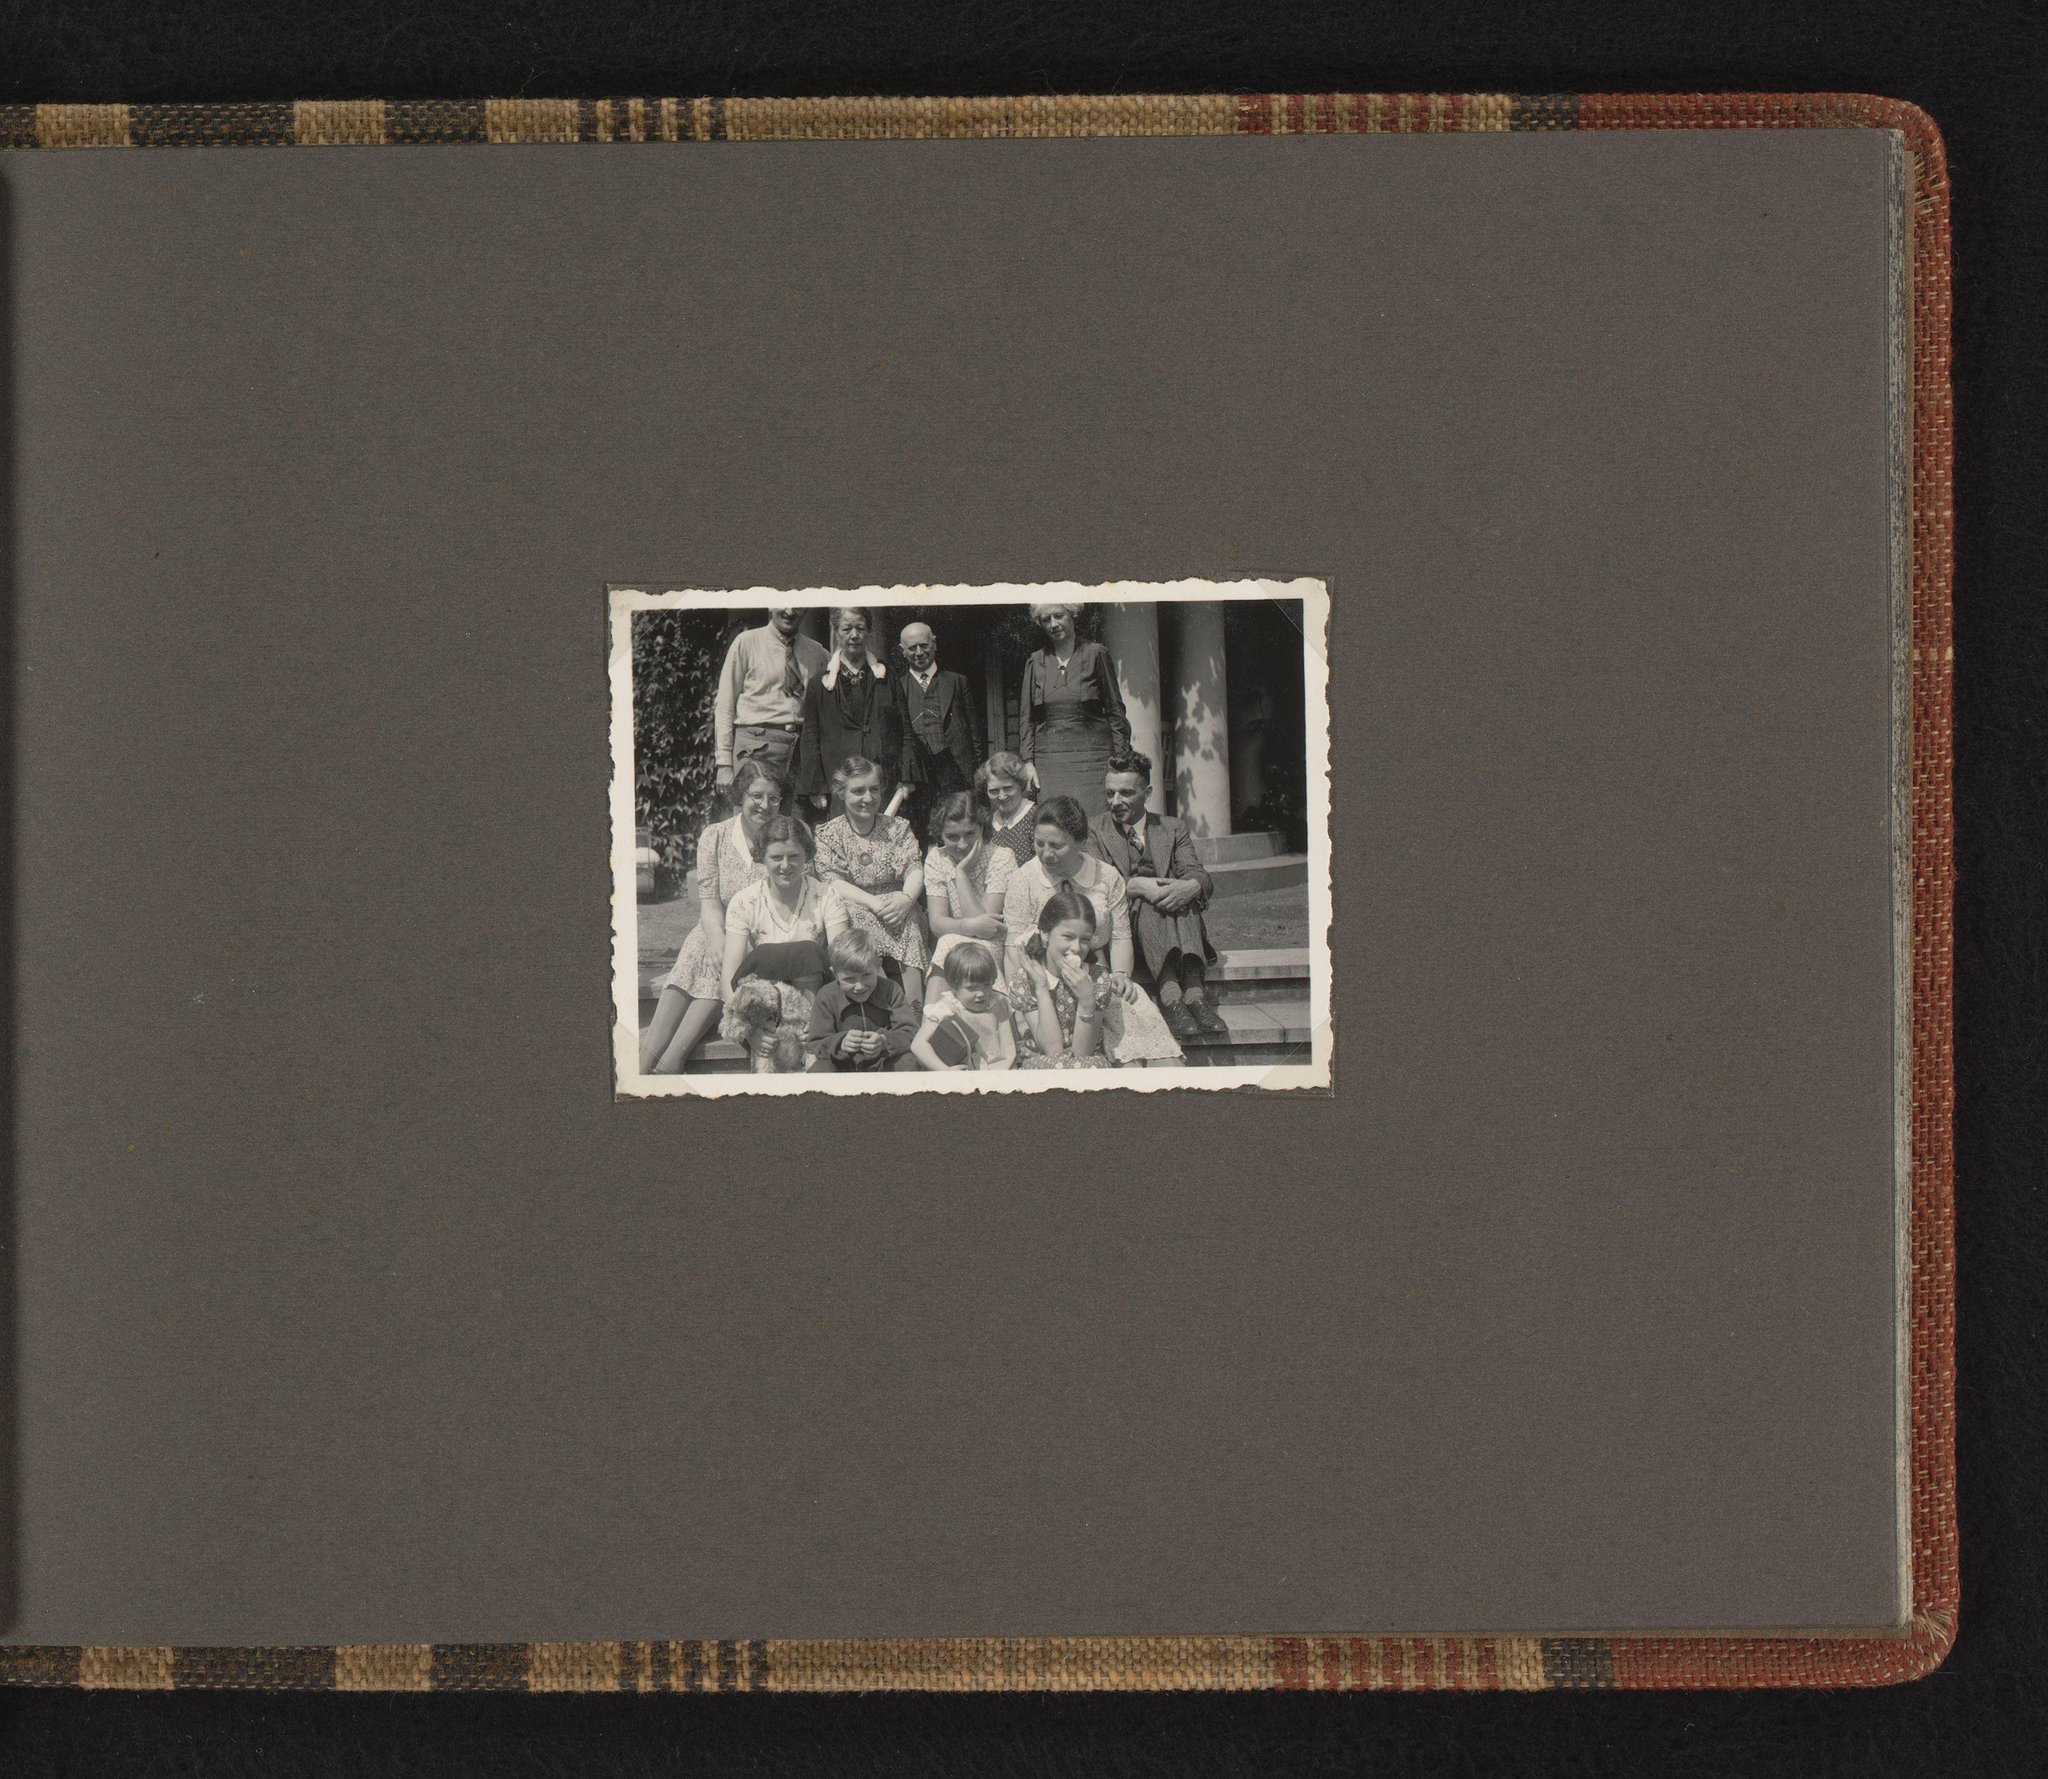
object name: album leaf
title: Groepsportret voor Huize Okkenbroek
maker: Anonymous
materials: paper, photographic support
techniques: gelatin silver print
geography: okkenbroek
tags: anonymous historical persons portrayed in a group, in a group-portrait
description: Deze pagina maakt deel uit van een album.